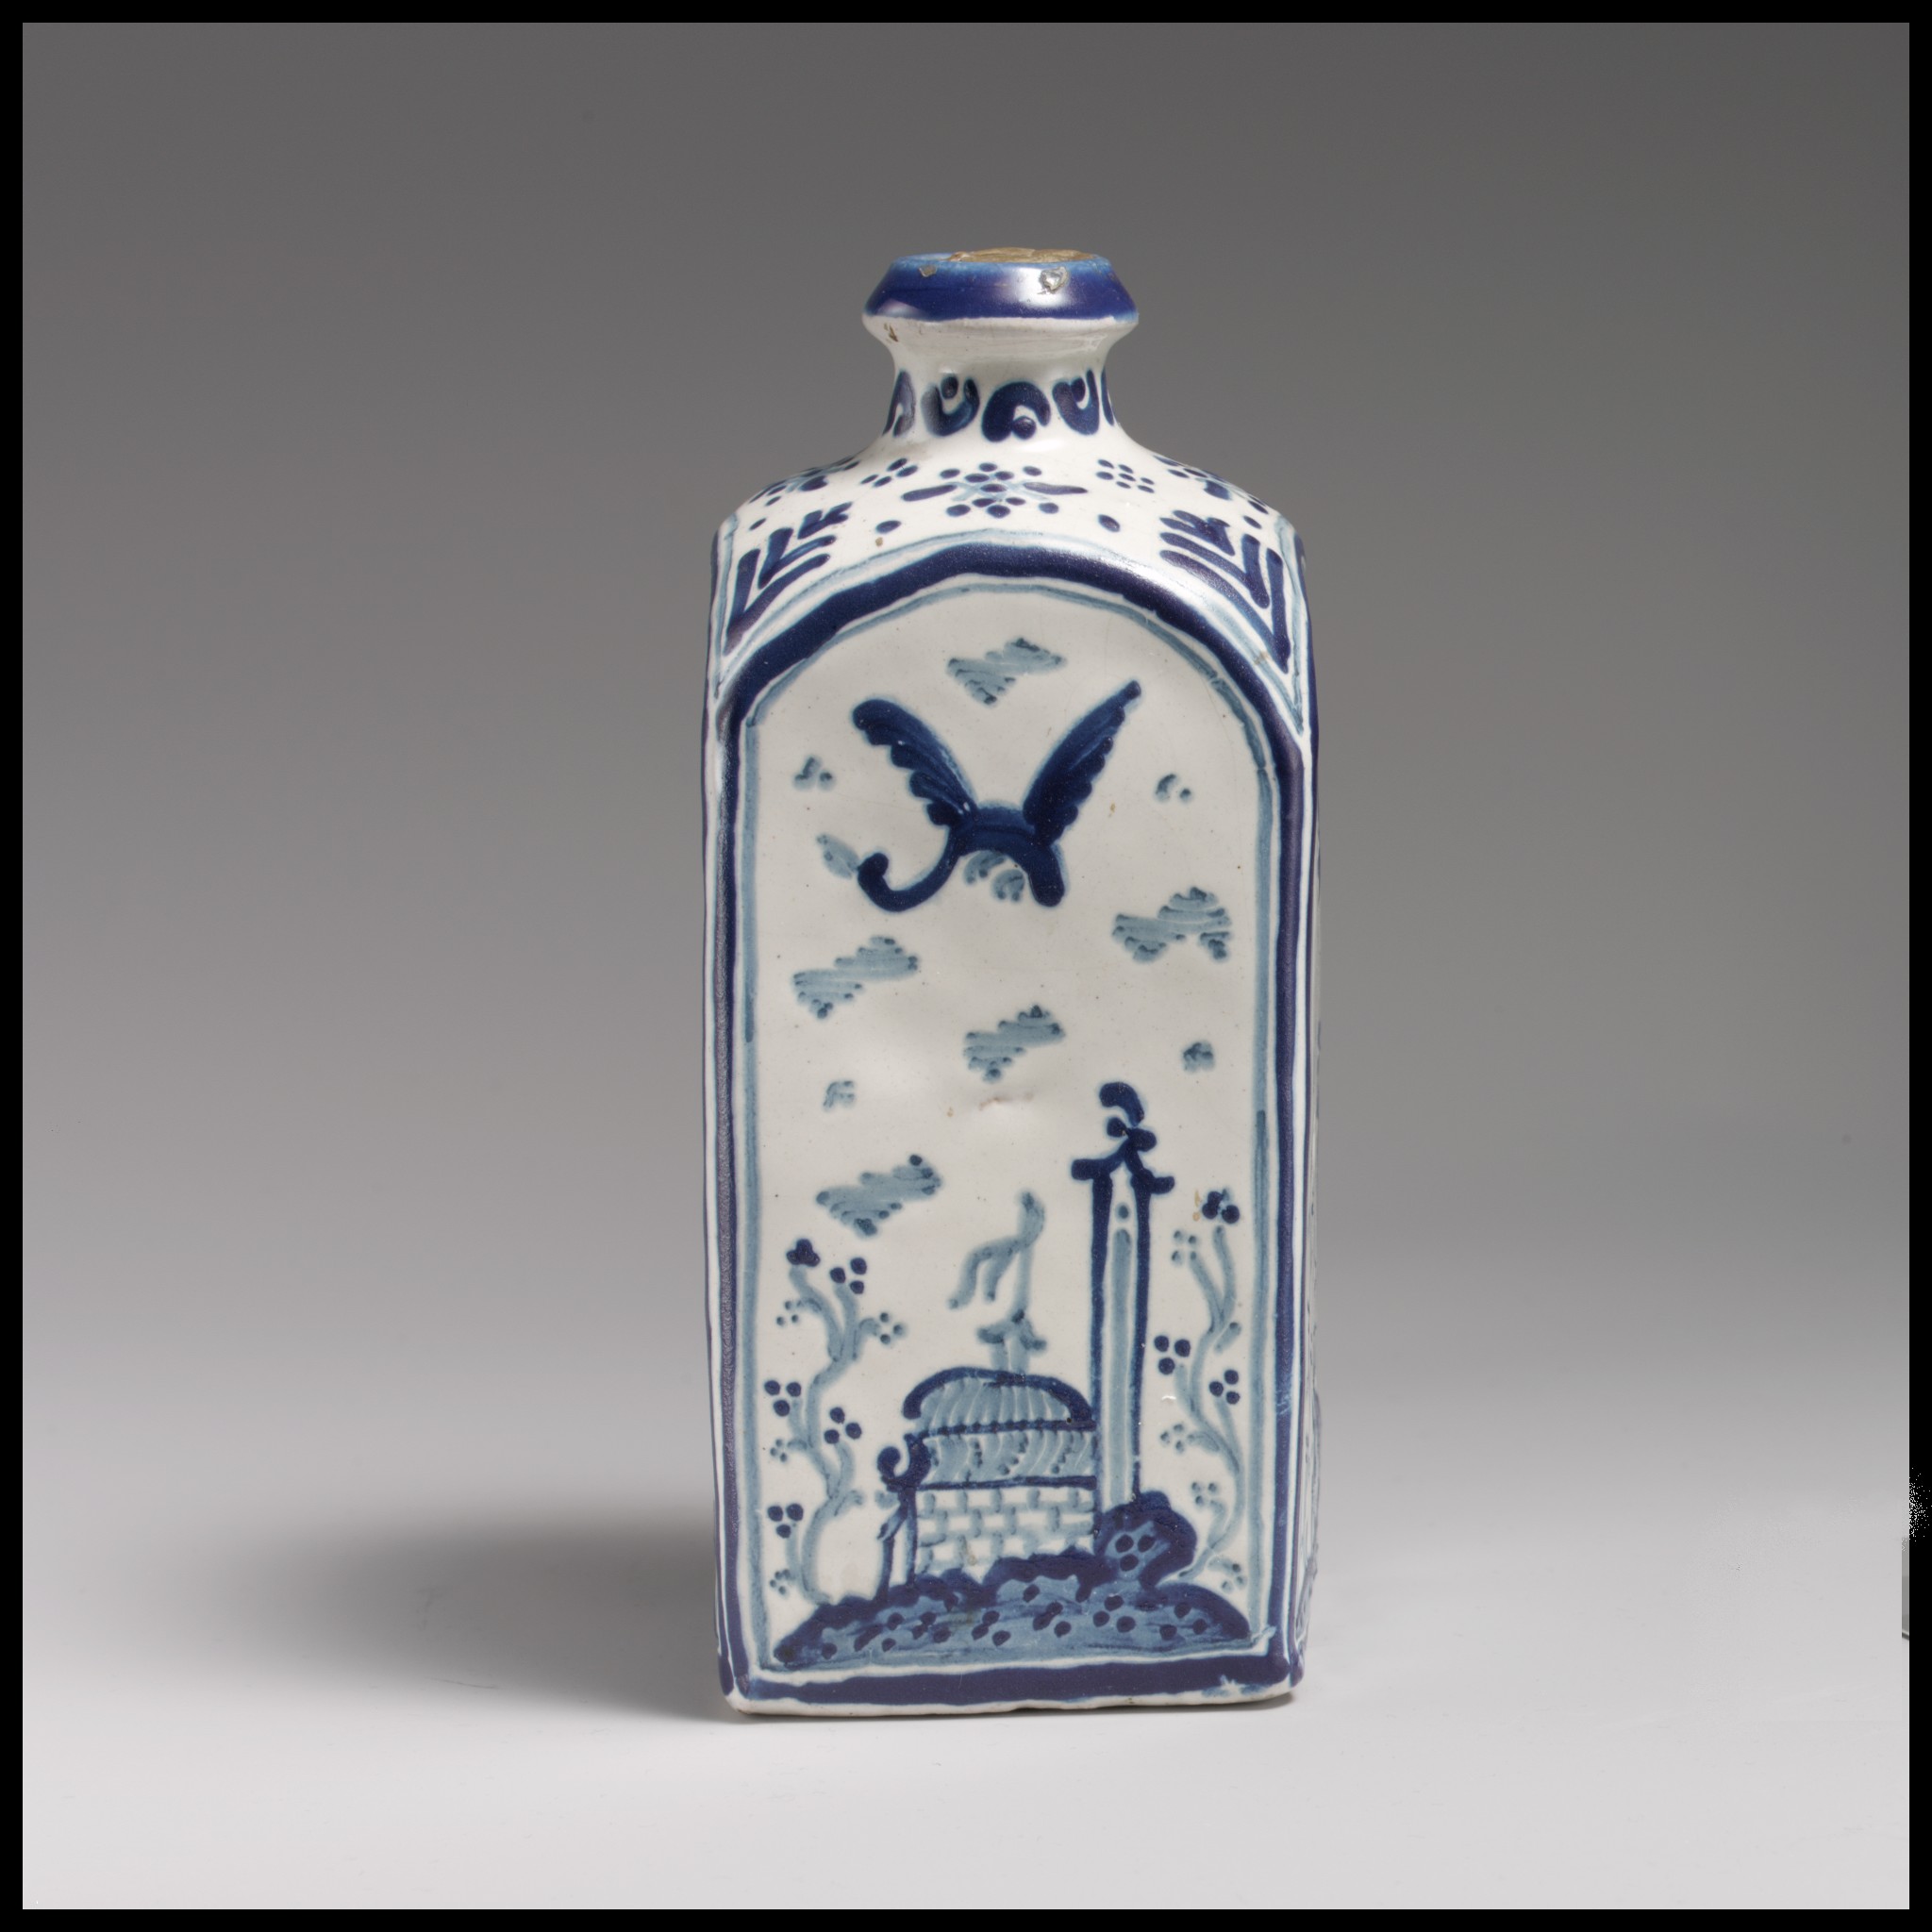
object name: bottle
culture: mexican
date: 1800-1900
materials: earthenware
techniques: glazing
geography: mexico